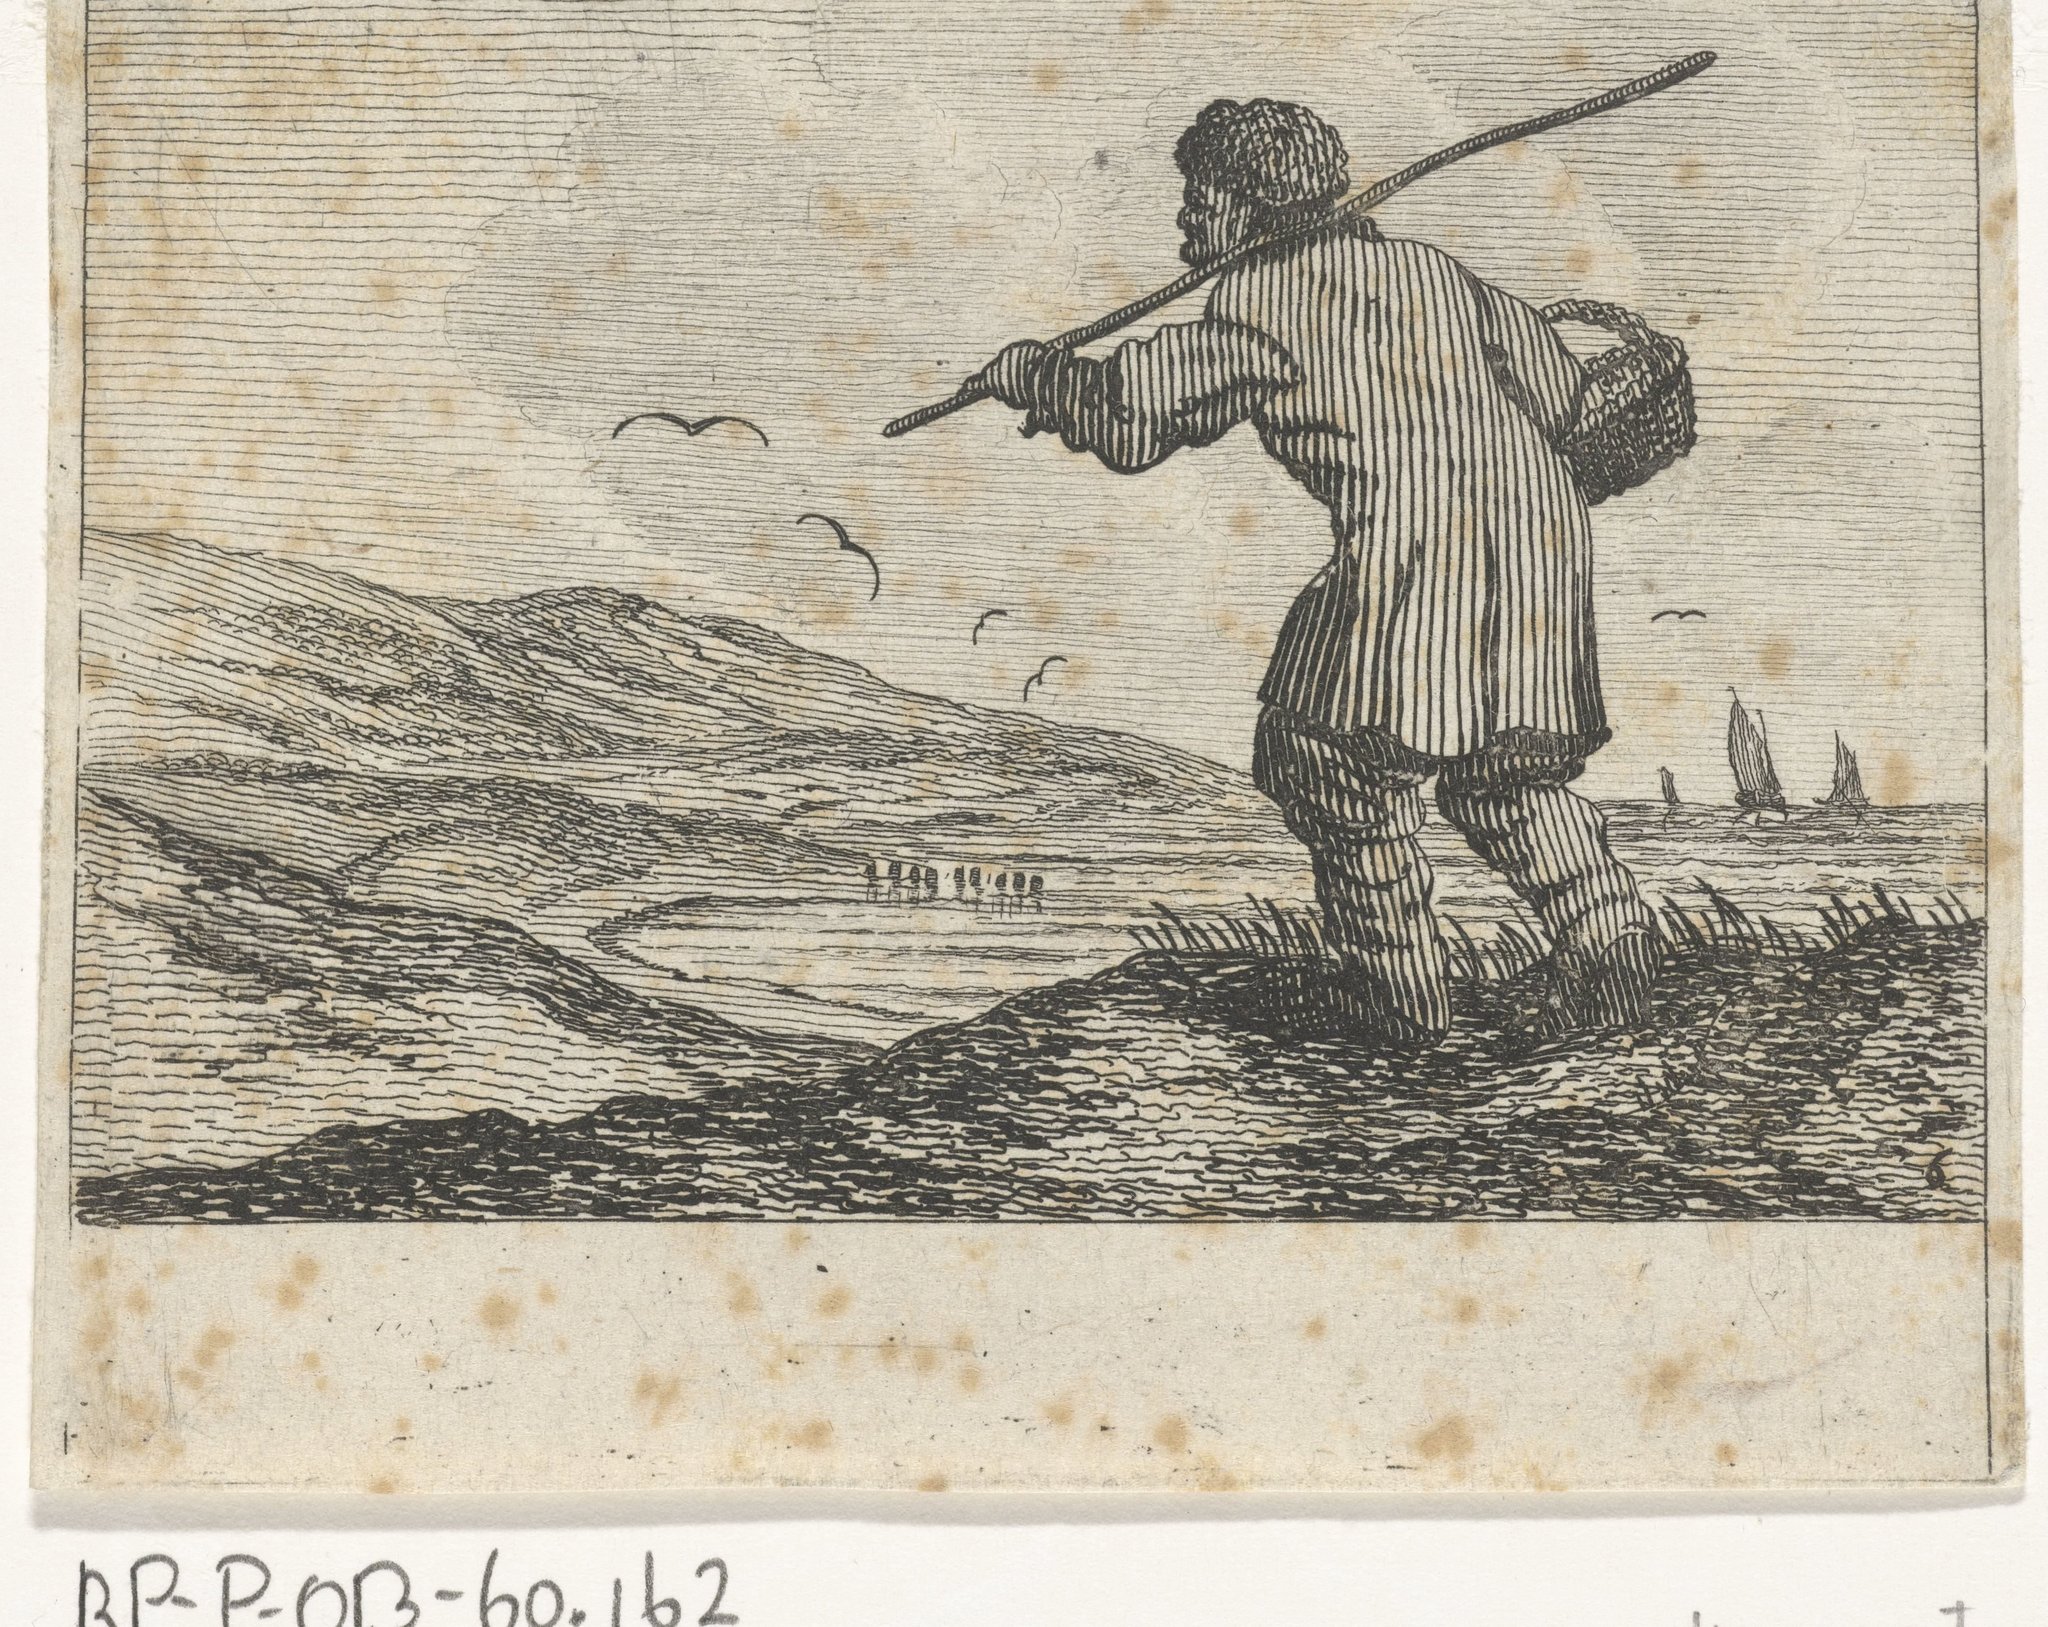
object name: print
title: Verscheyden Stranden en water gesichten gedaen door Jan Percelles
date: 1618-1645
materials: paper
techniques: etching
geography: haarlem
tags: dune coast, carrying something in basket, bag, rucksack, etc.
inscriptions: collector's mark: Lugt 240